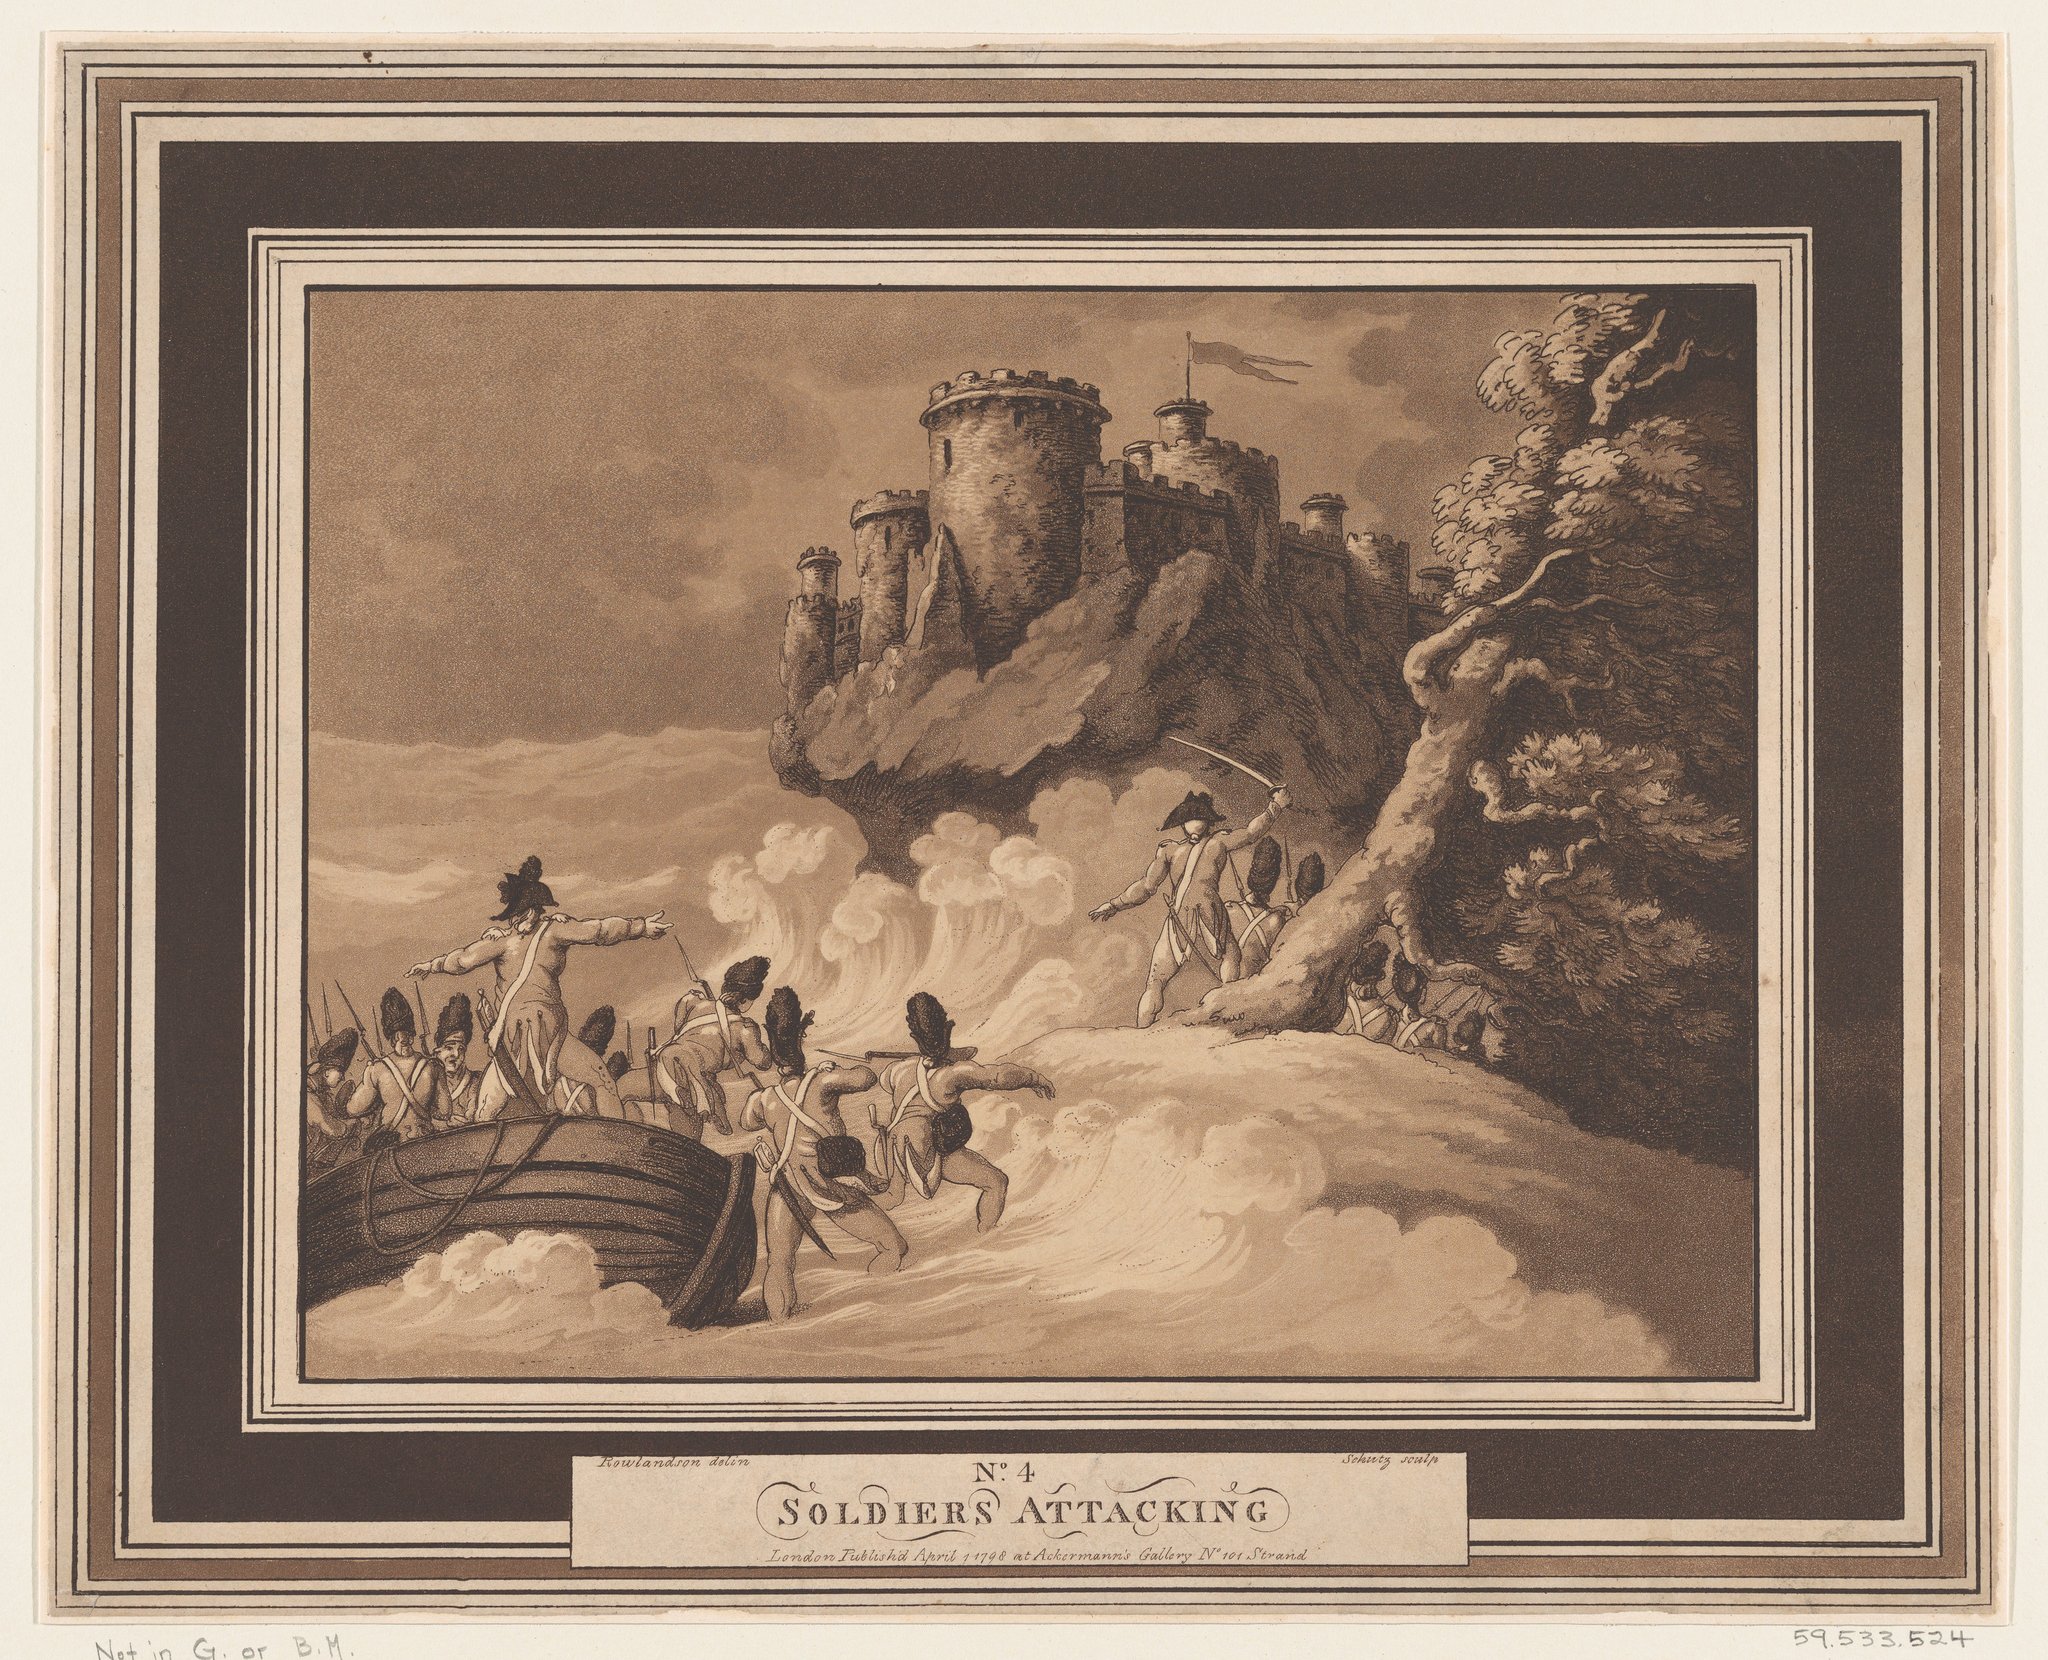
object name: print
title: Soldiers Attacking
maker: heinrich joseph schütz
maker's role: artist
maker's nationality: german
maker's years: 1800-1825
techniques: aquatint, etching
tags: castles,soldiers,men,boats